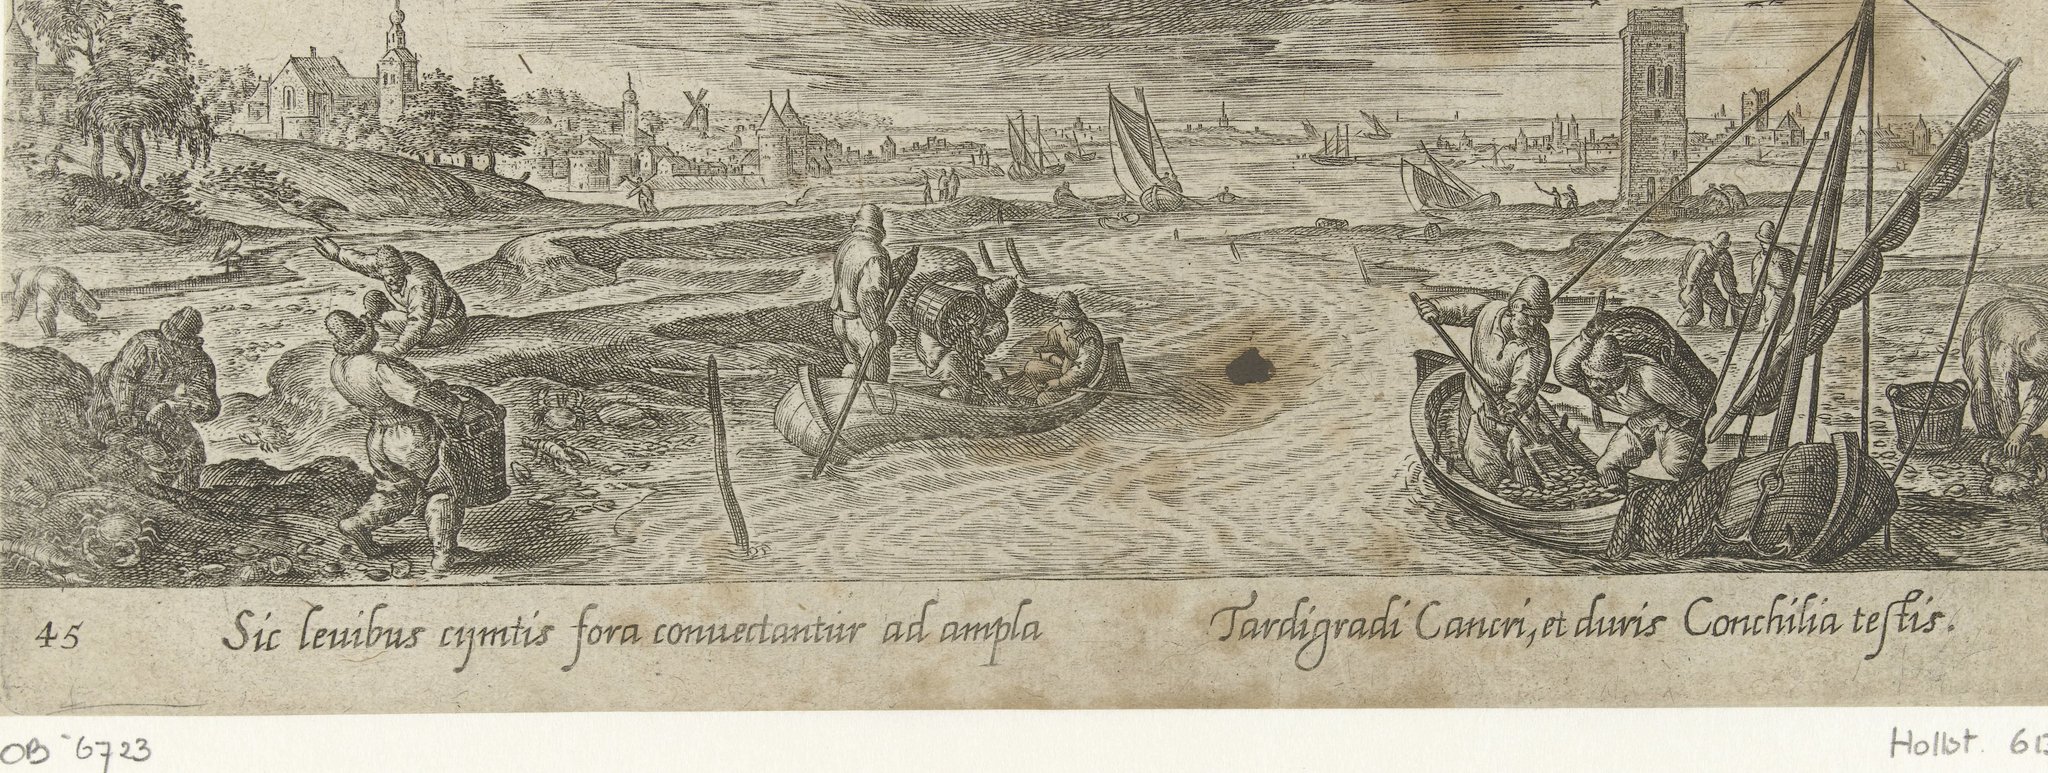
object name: print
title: Venationes, Piscationes et Aucupii Typi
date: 1582-1633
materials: paper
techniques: engraving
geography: antwerp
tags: oyster and mussel culture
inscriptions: collector's mark: Lugt 2228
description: Bij de delta van een rivier oogsten vissers mossels. De prent heeft een Latijns onderschrift en maakt deel uit van een serie van 54 prenten.